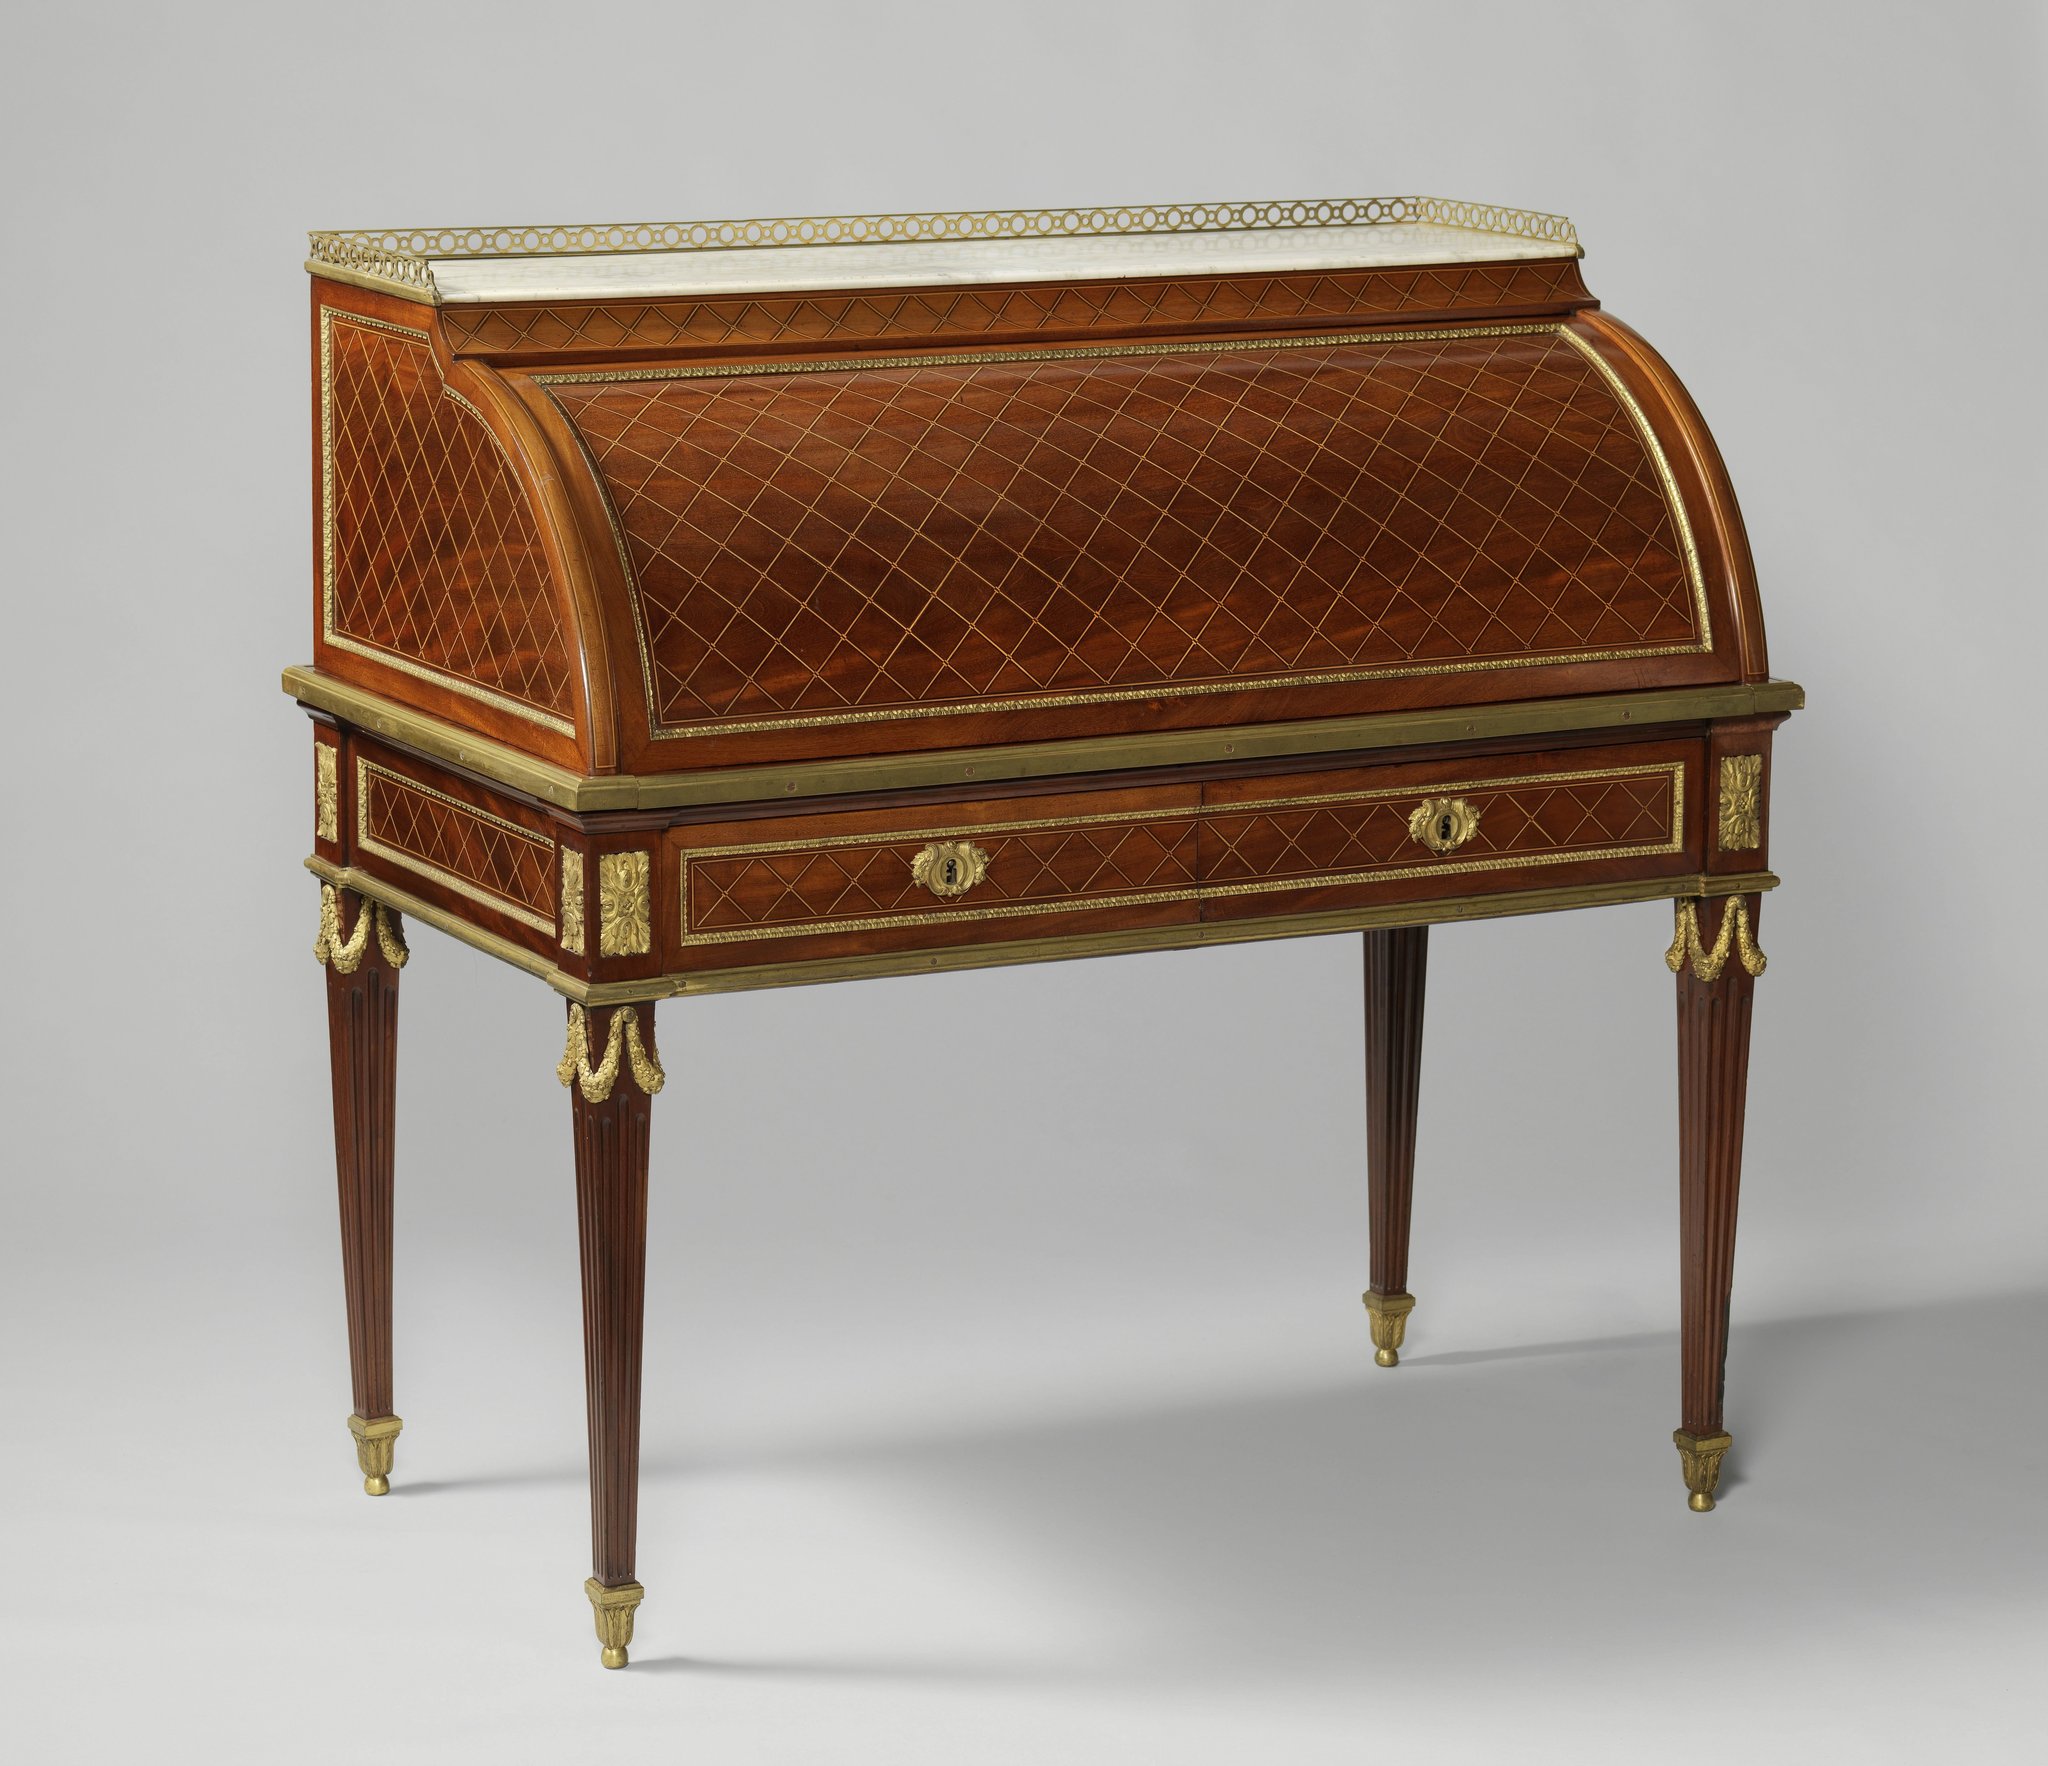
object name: furniture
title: Cylinder-top Desk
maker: jean françois leleu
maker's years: 1729-1807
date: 1775-1785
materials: wood, bronze, leather, marble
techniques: gilding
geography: paris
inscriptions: signature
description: When the writing slide of this desk is drawn out, the cylinder automatically disappears into the superstructure, revealing the desk’s interior. Leleu was a pupil of the famous Jean-François Oeben who specialized in ingenious mechanical furniture of this kind. The relatively sober decoration of this mahogany piece shows the influence of contemporary English taste at the time.